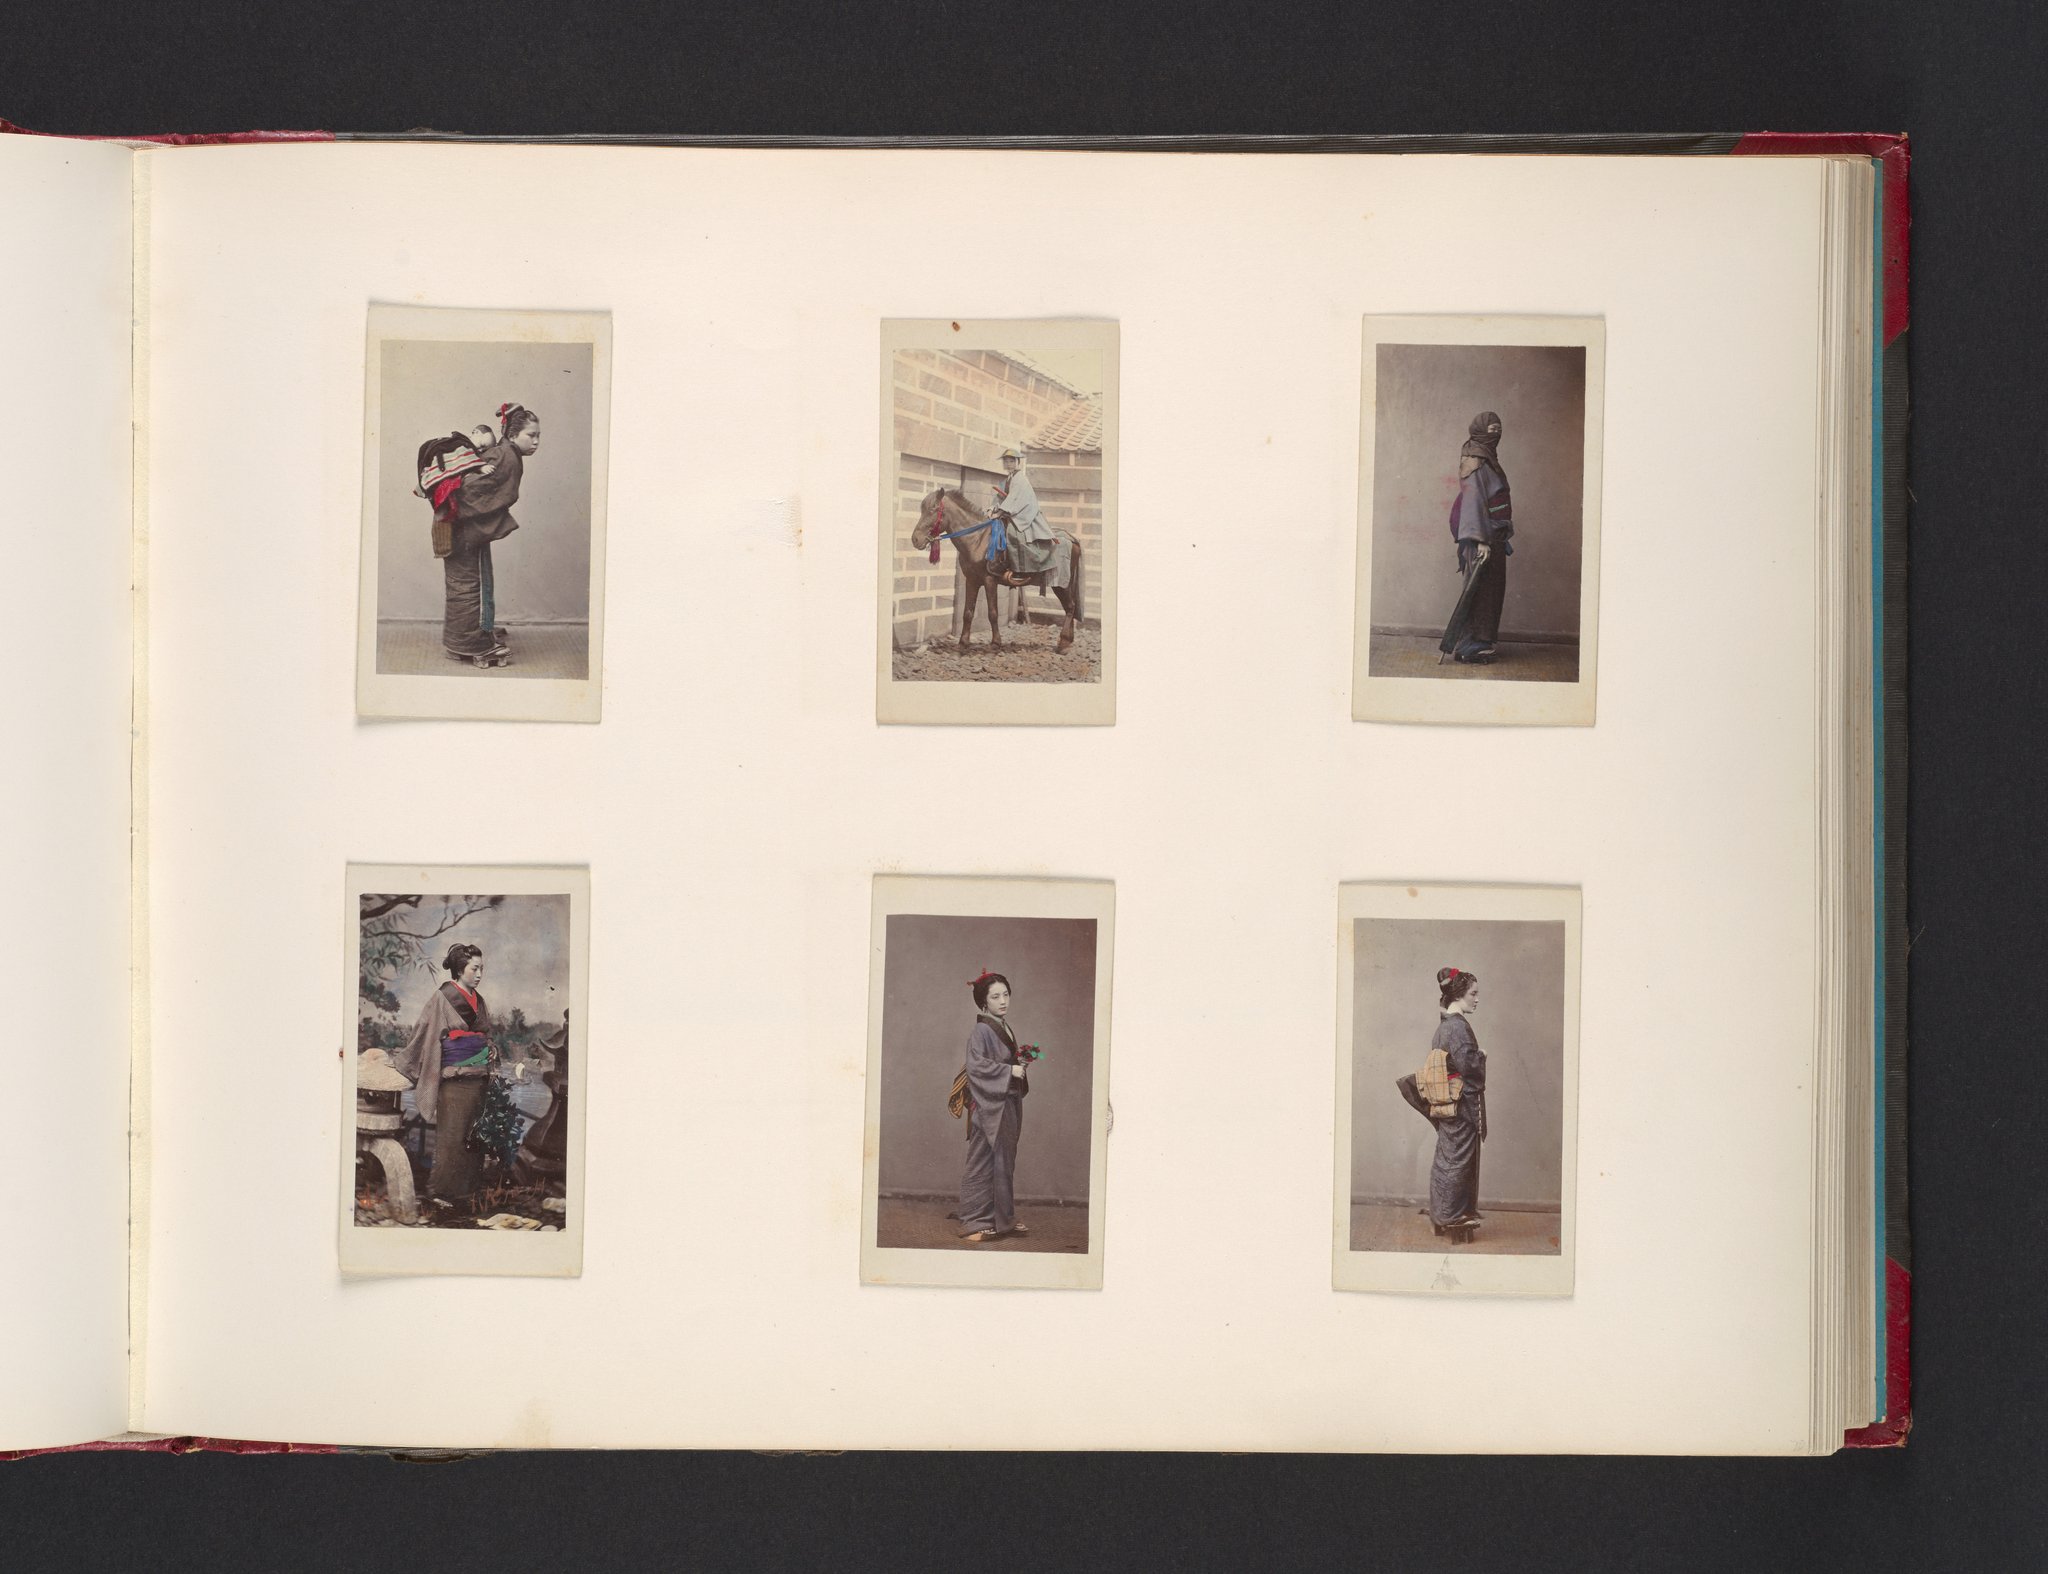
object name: photograph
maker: john thomson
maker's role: artist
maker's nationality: british, scottish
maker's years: 1837-1921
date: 1865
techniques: albumen silver print, glass negative